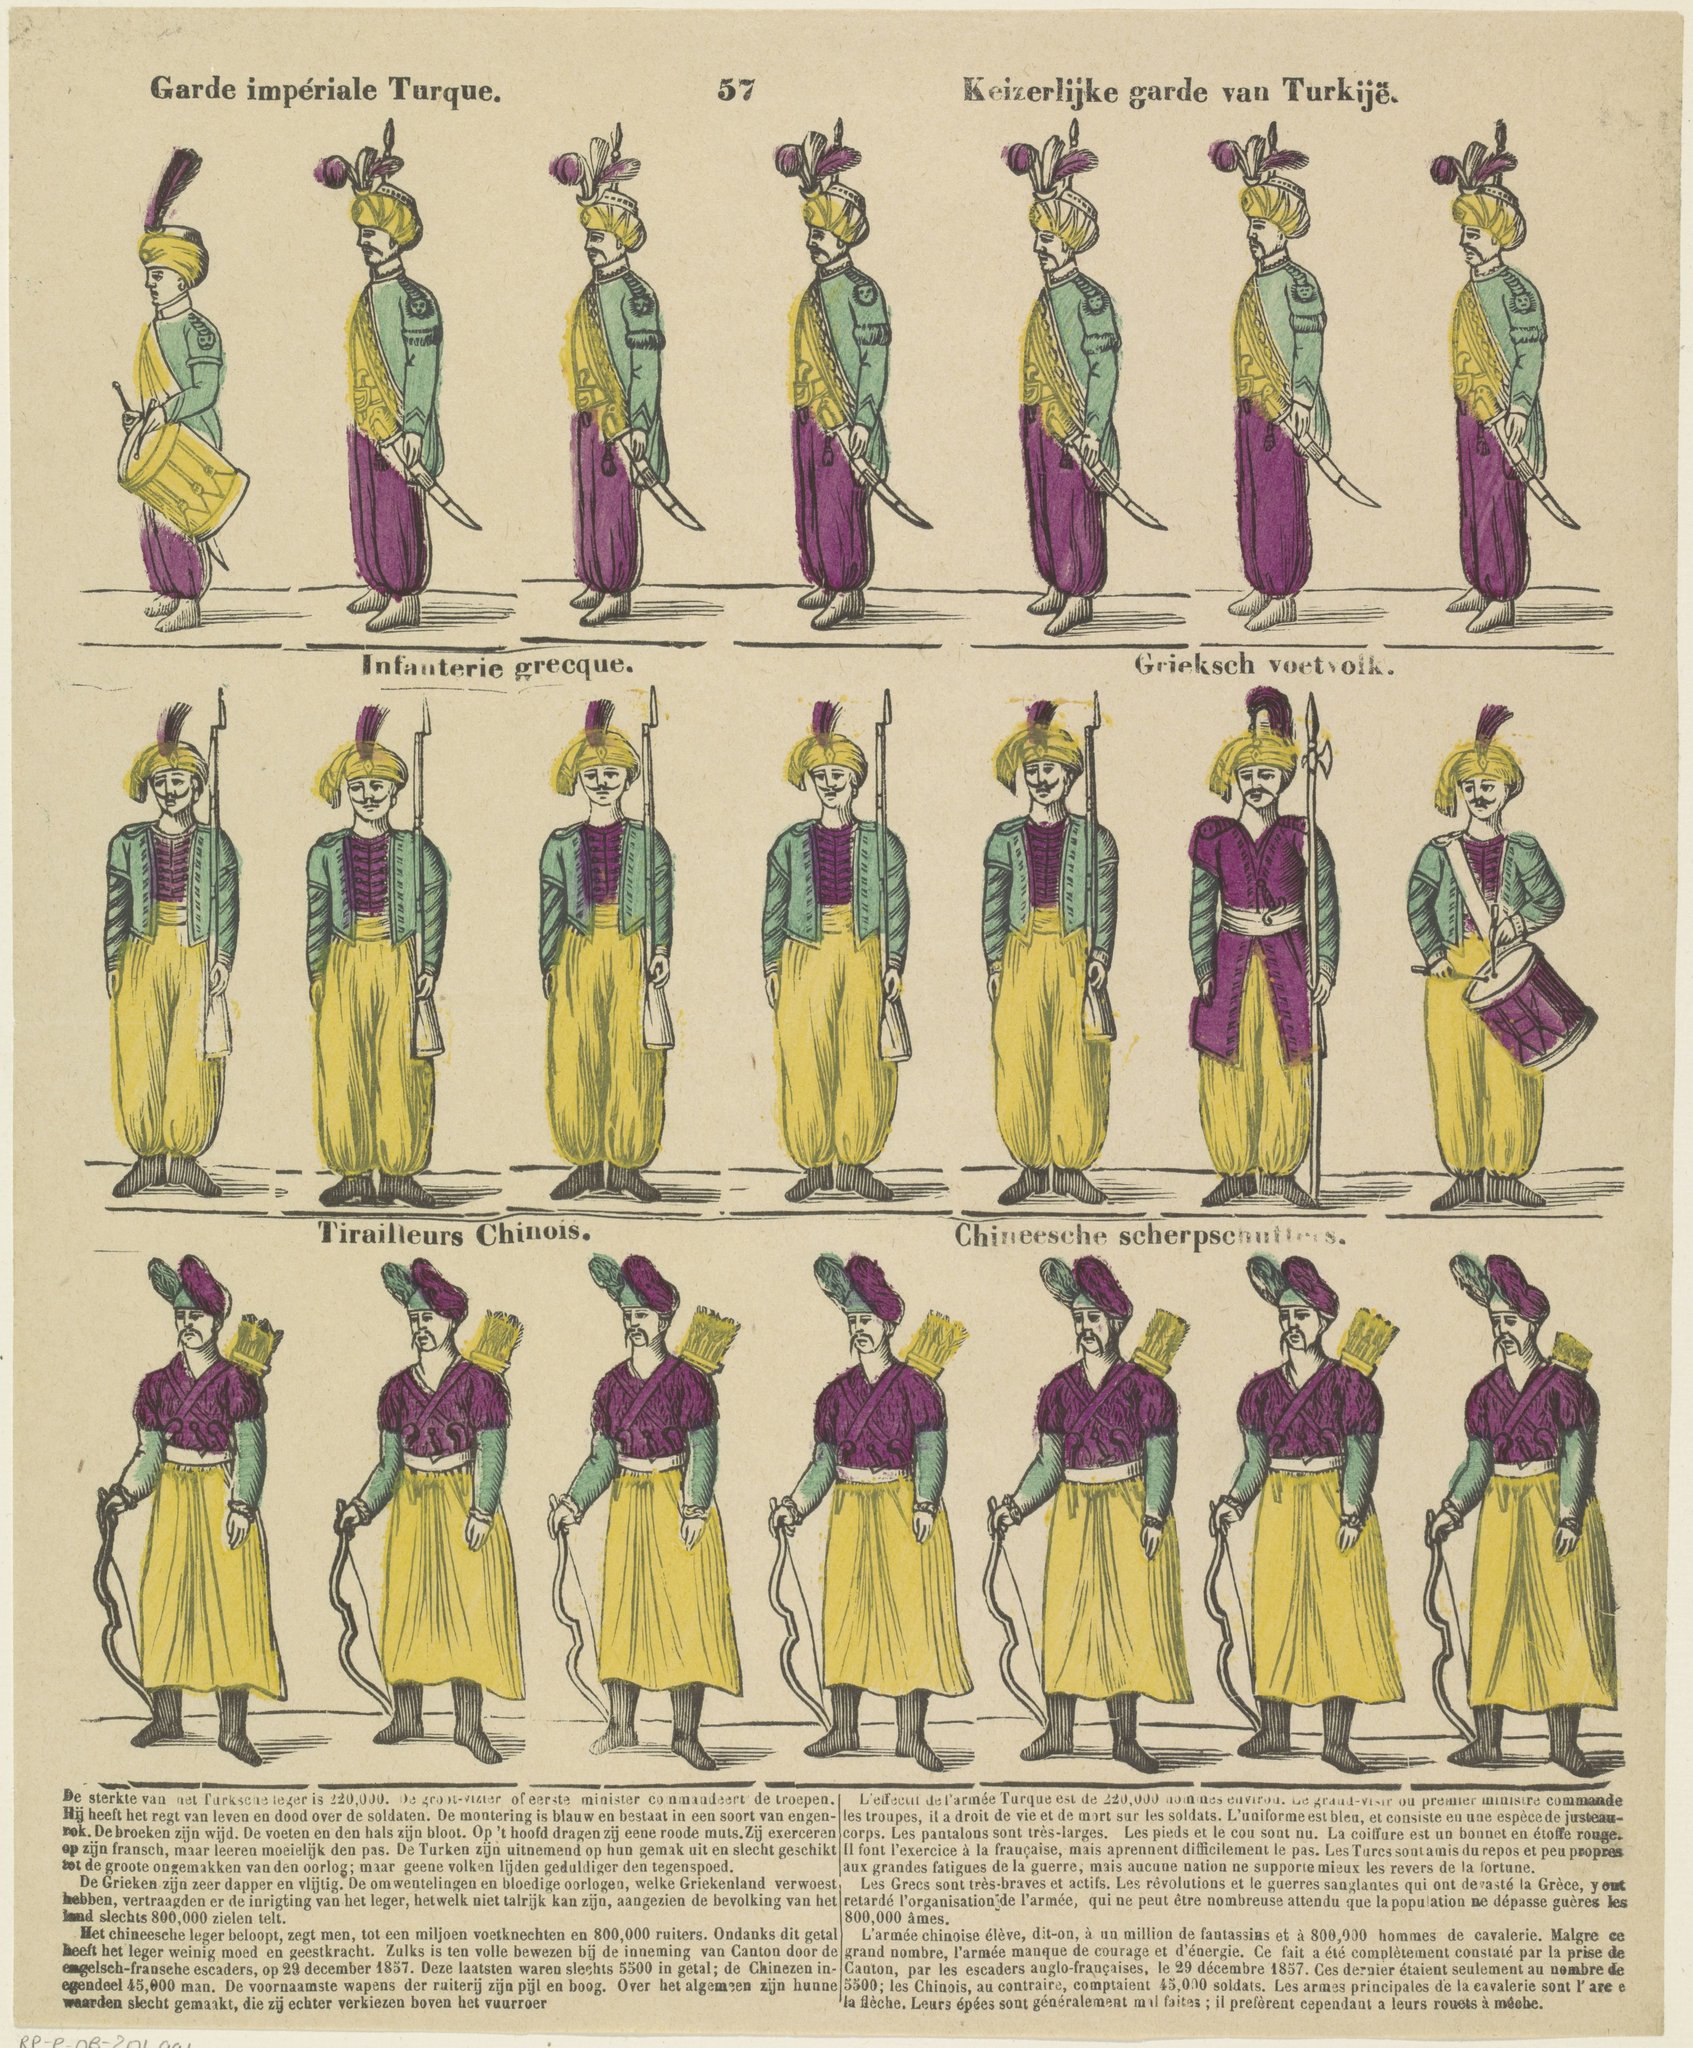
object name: print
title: Garde impériale Turque / Keizerlijke garde der Turkijë [(...)]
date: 1800-1833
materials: paper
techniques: colour, letterpress printing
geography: turnhout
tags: the soldier; the soldier's life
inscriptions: collector's mark: Lugt 2760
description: Blad met 3 horizontale rijen met in totaal 21 voorstellingen van Turkse, Chinese en Griekse soldaten. Een onderschrift in het Nederlands en in het Frans in twee kolommen. Genummerd midden boven: 57.